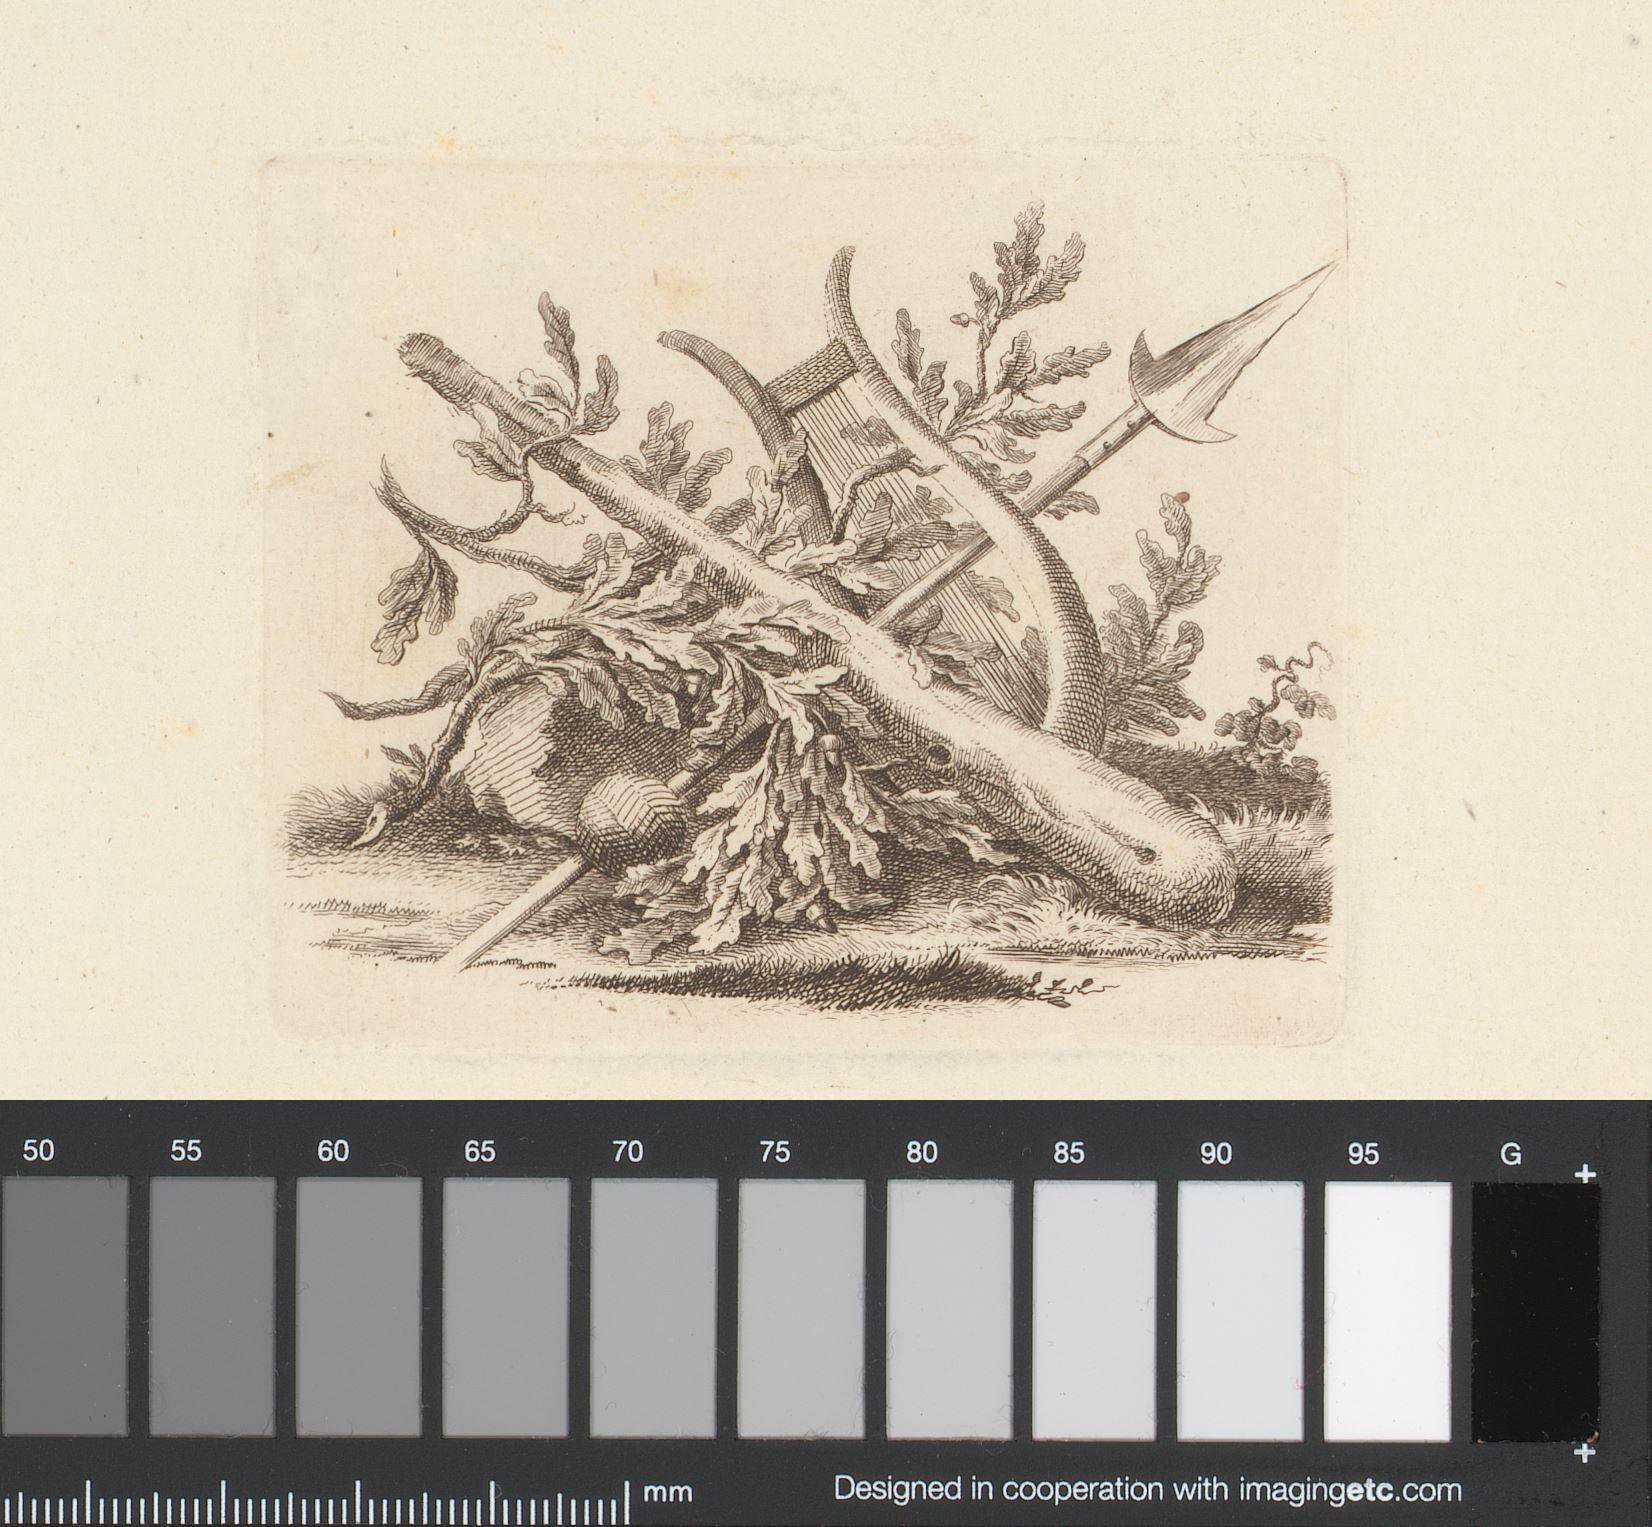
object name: print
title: Lier met knots en speer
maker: carl friedrich holtzmann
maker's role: print maker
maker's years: 1740-1811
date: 1750-1811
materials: paper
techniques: etching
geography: dresden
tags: lyre, cithara, psaltery, casting weapons: spear, weapons for striking a blow: club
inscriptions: collector's mark: Lugt 2228, collector's mark: Lugt 2760